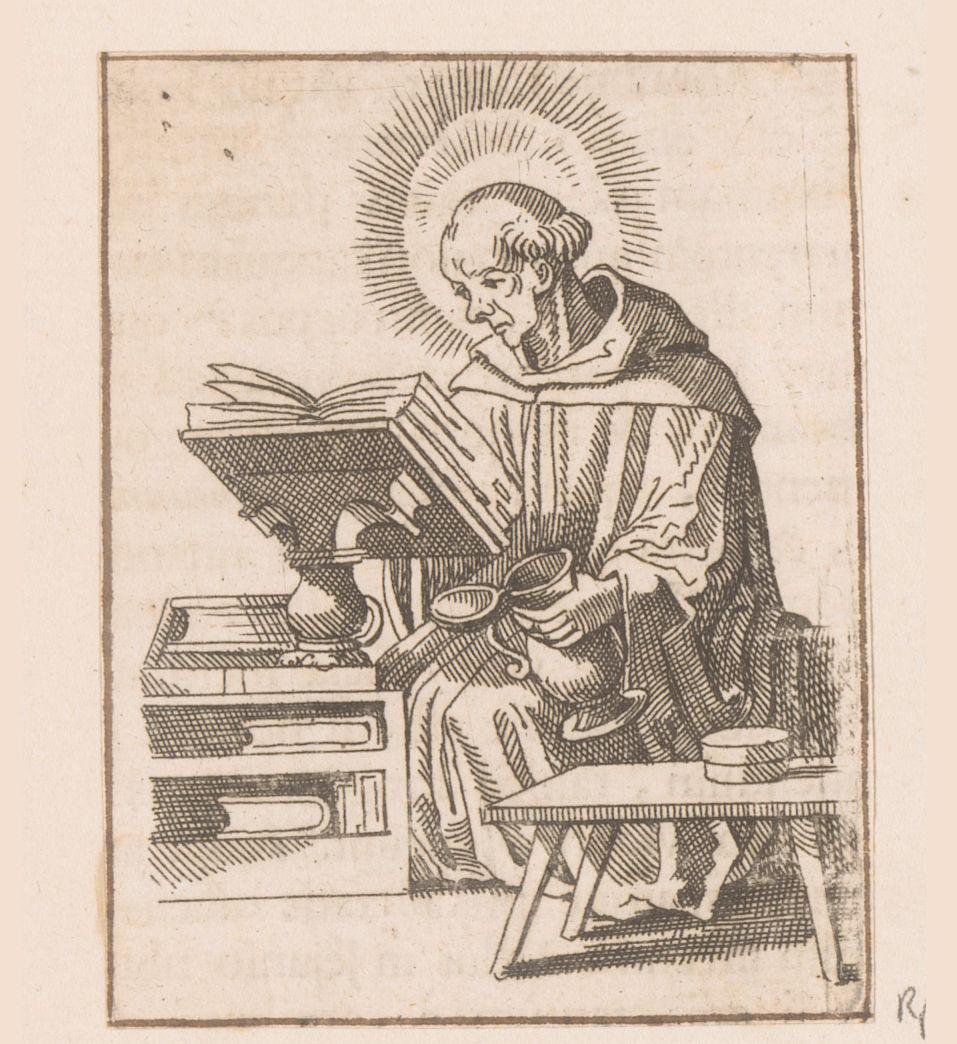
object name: book illustration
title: Illustraties uit de Lof der Zotheid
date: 1516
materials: paper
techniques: etching, letterpress printing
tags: rotterdam, desiderius erasmus, bernard of clairvaux, cistercian monk and abbot; possible attributes: beehive, chained dragon, crucifix, cross with instruments of the passion, (three) mitre at his feet, white dog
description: Prent afkomstig uit: Erasmus, Desiderius. Morias enkomion (...). Bazel: Johann Rudolf Genath, 1676. De prenten hierin zijn naar tekeningen die Hans en Ambrosius Holbein maakten voor de theoloog Oswald Myconius in diens uitgave van de Moriae encomium (Lof der Zotheid) van 1516.